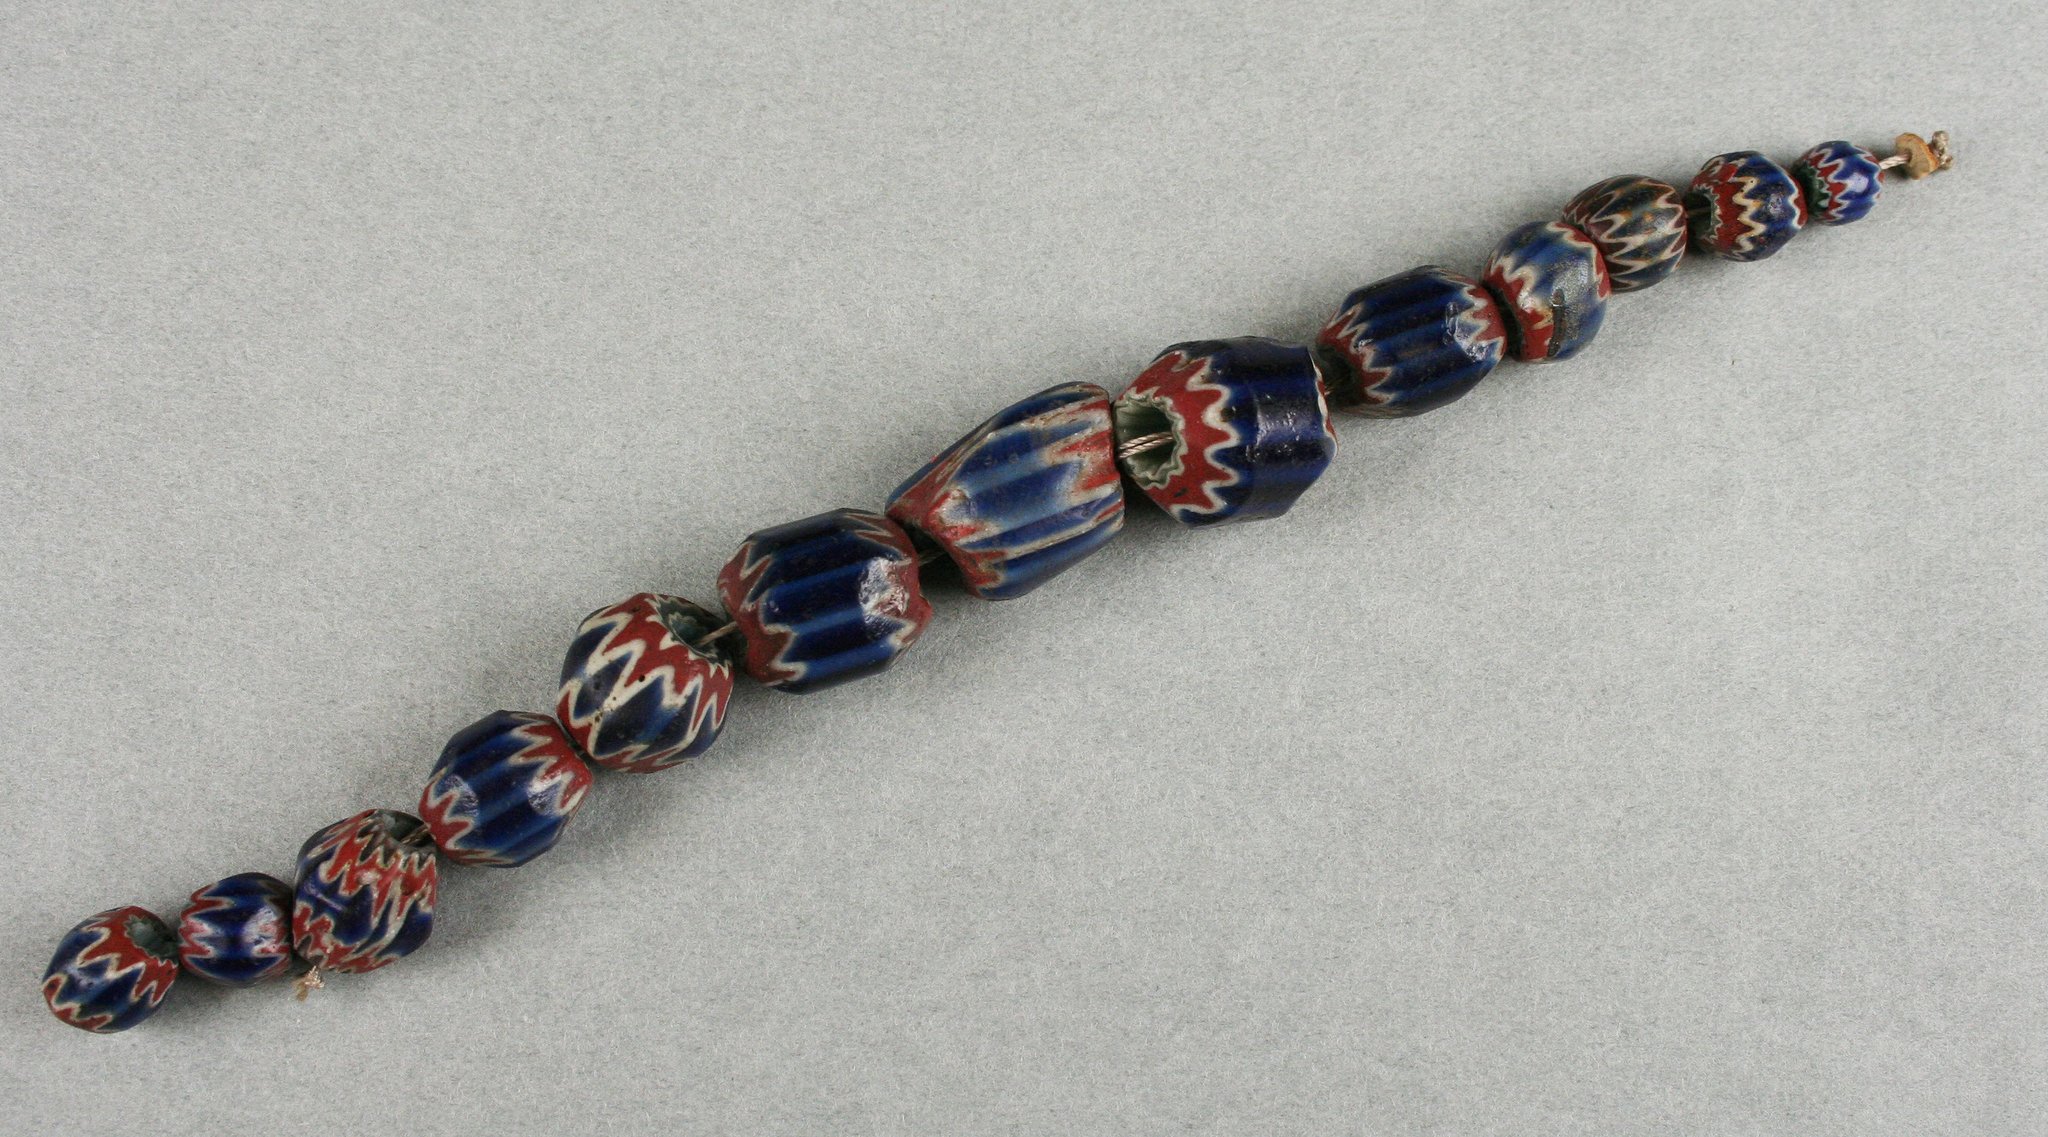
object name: bead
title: Chevron Beads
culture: african or european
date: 1701-1800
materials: glass